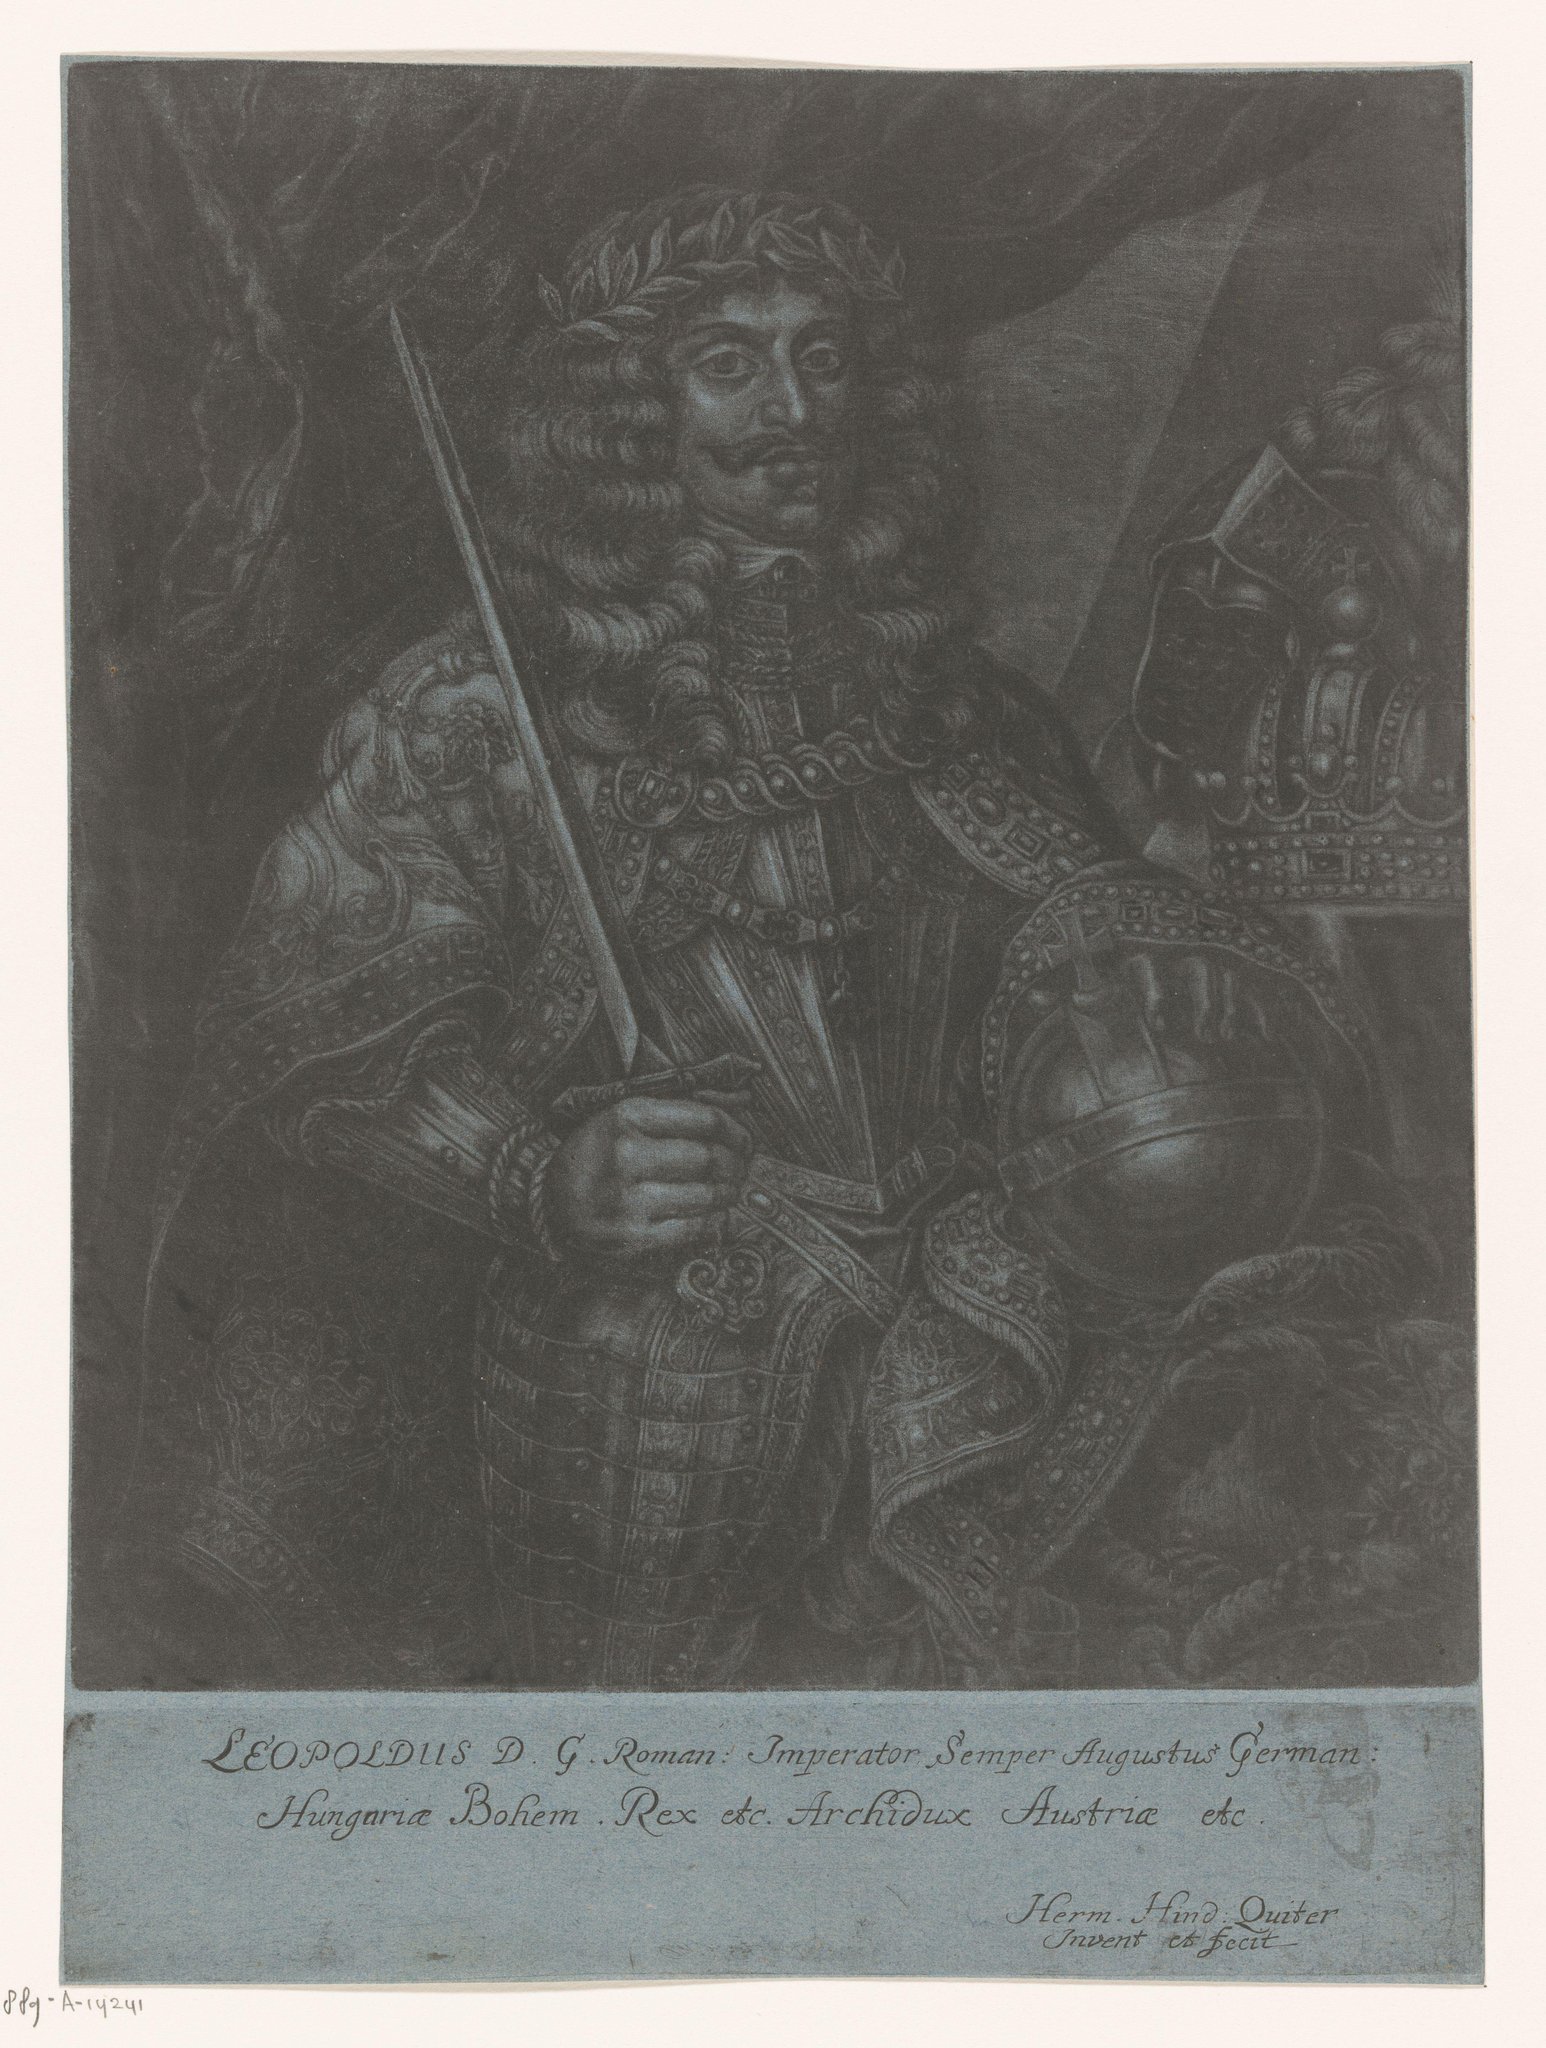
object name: print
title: Portret van keizer Leopold I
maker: herman hendrik de quiter (i)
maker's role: painter, print maker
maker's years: 1627-1708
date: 1657-1708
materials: paper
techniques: mezzotint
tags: vienna, leopold i (keizer van duitsland), historical persons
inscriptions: collector's mark: Lugt 2228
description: Portret van keizer Leopold I van Duitsland, staande tot aan de knieën, een weinig rechts gewend, met lange krullende op de schouders afhangende haren en lauwerkrans op het hoofd. In harnas, waarover een rijk met edelgesteenten en paarlen versierden mantel. In de rechterhand het Rijkszwaard houdende, met de linkerhand rustend op een rijksappel. Rechts een keizerskroon en een helm op een tafel.